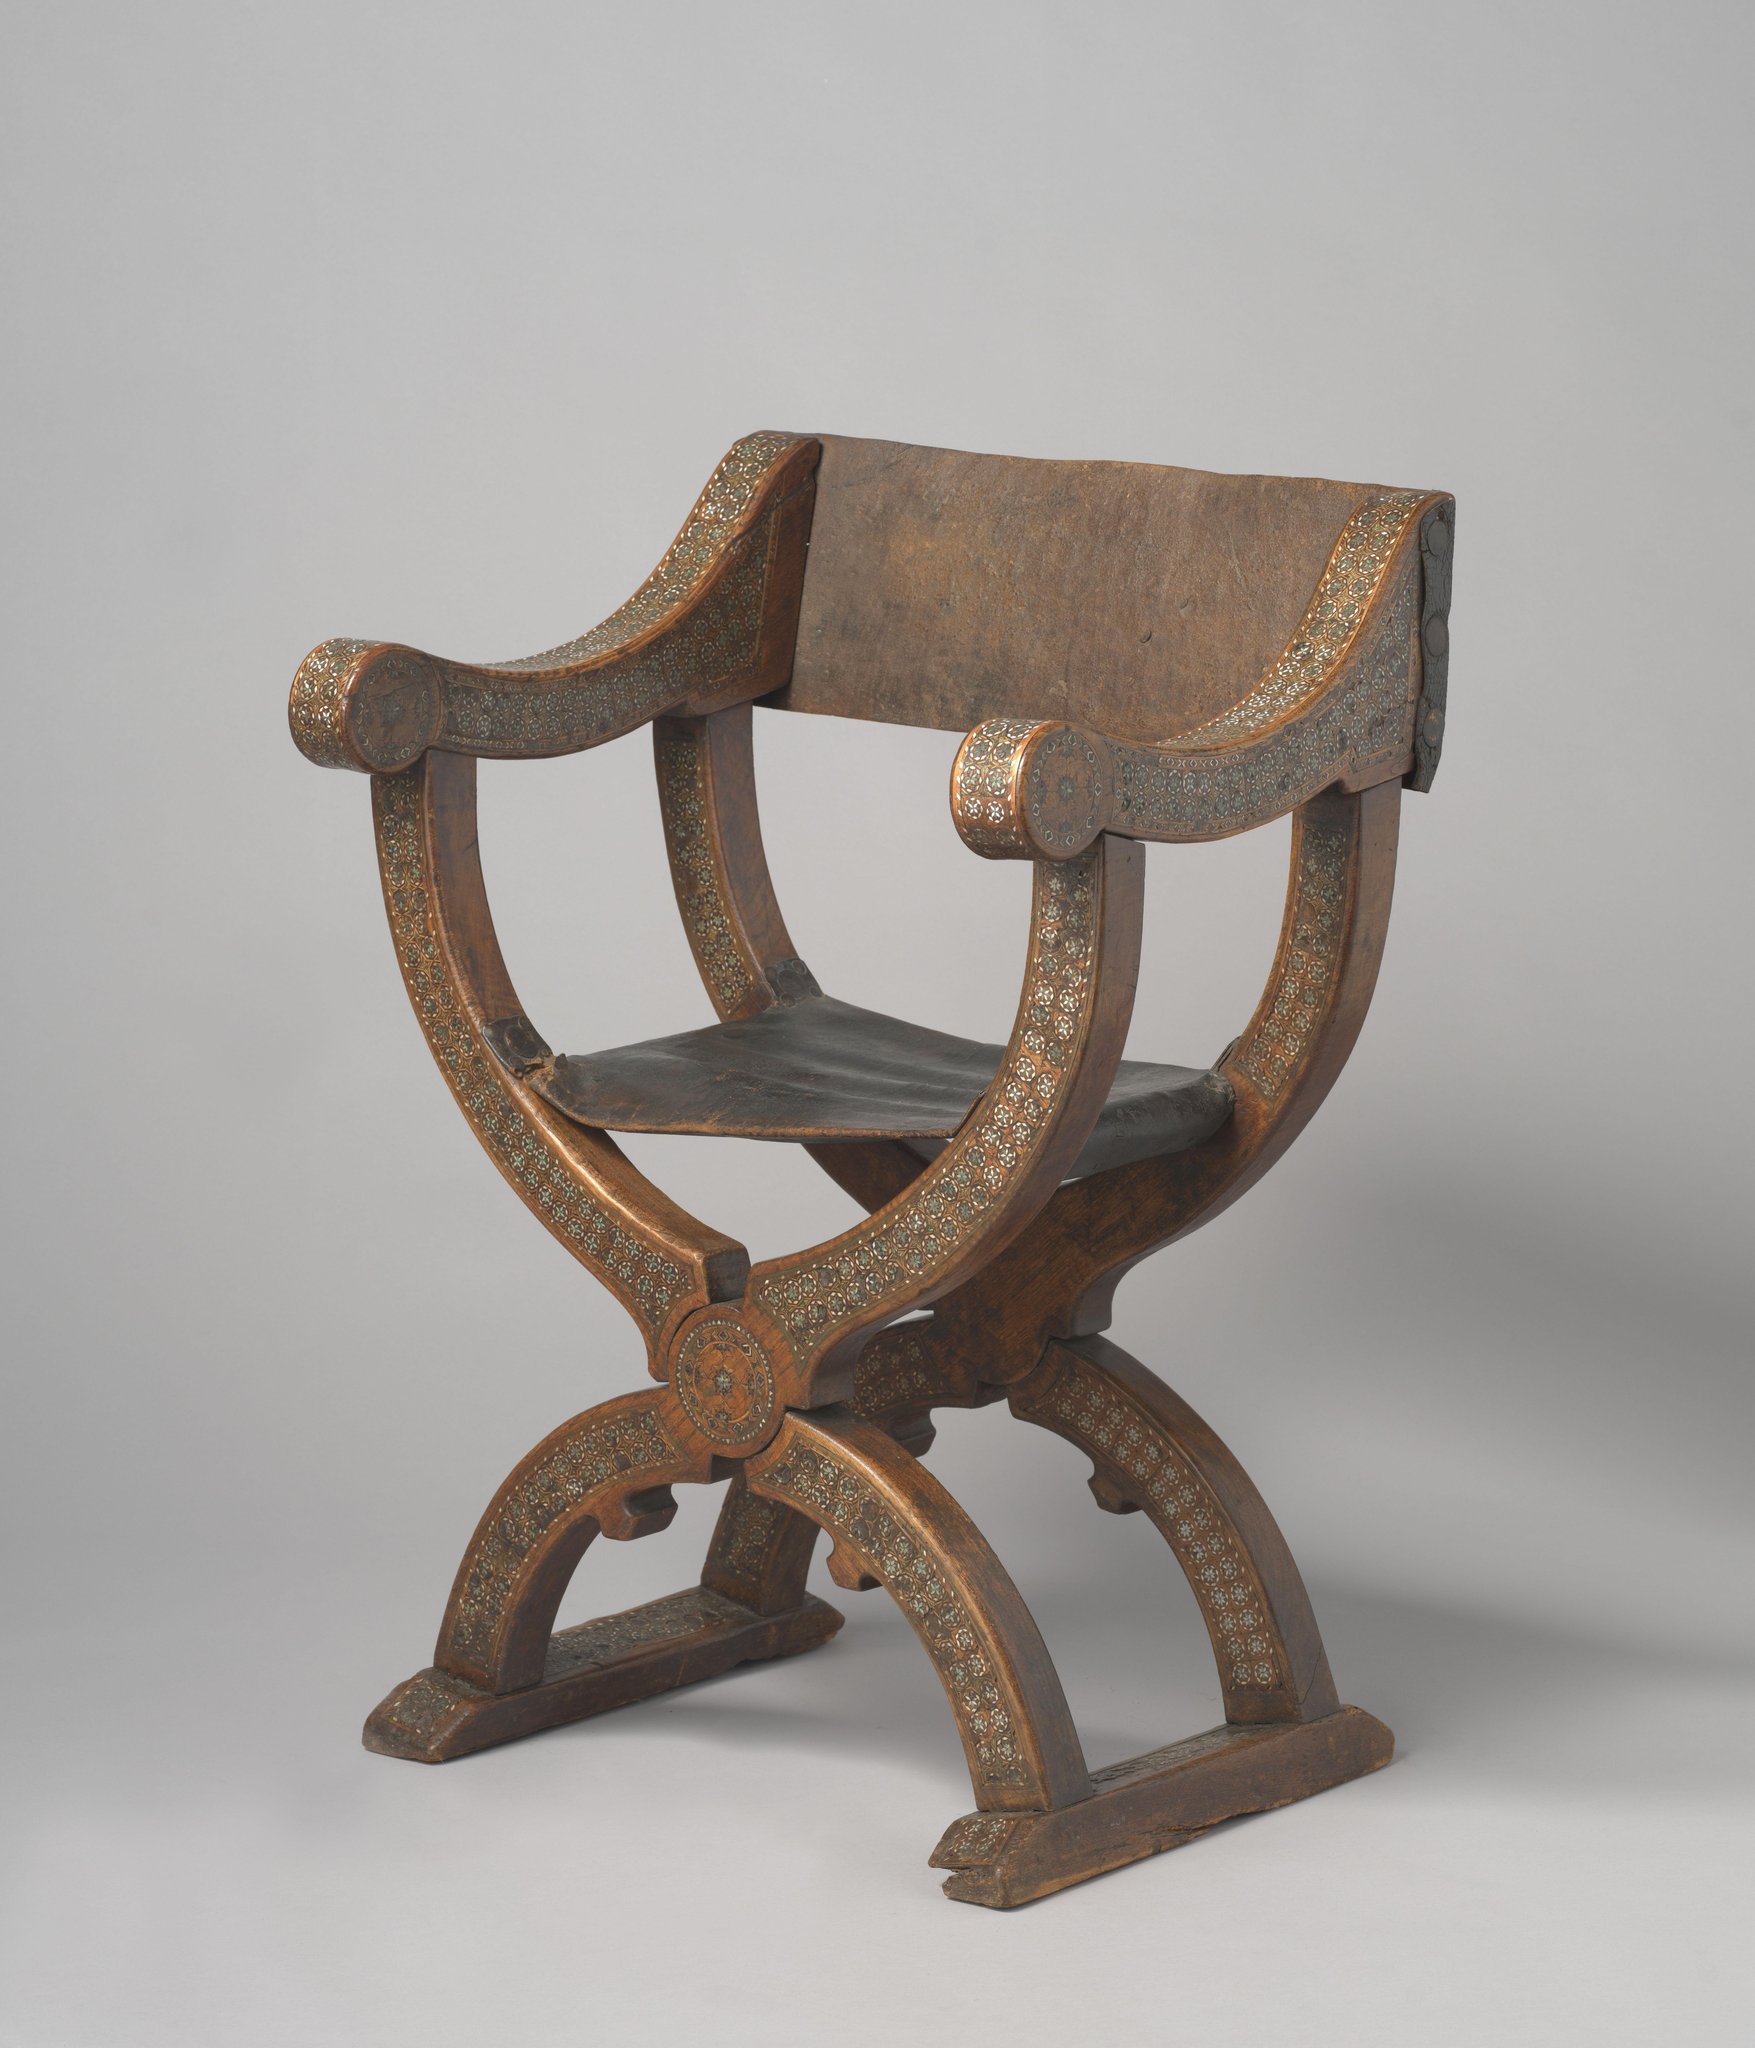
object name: seating furniture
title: Vouwstoel van iepenhout, met leren rug en zitting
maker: Anonymous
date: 1500-1600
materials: bone, wood, leather, mother of pearl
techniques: marquetry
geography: northern italy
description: Folding chair. Elm, inlaid with bone, mother-of-pearl and various woods, the leather upholstery renewed. Italy, 16th century.